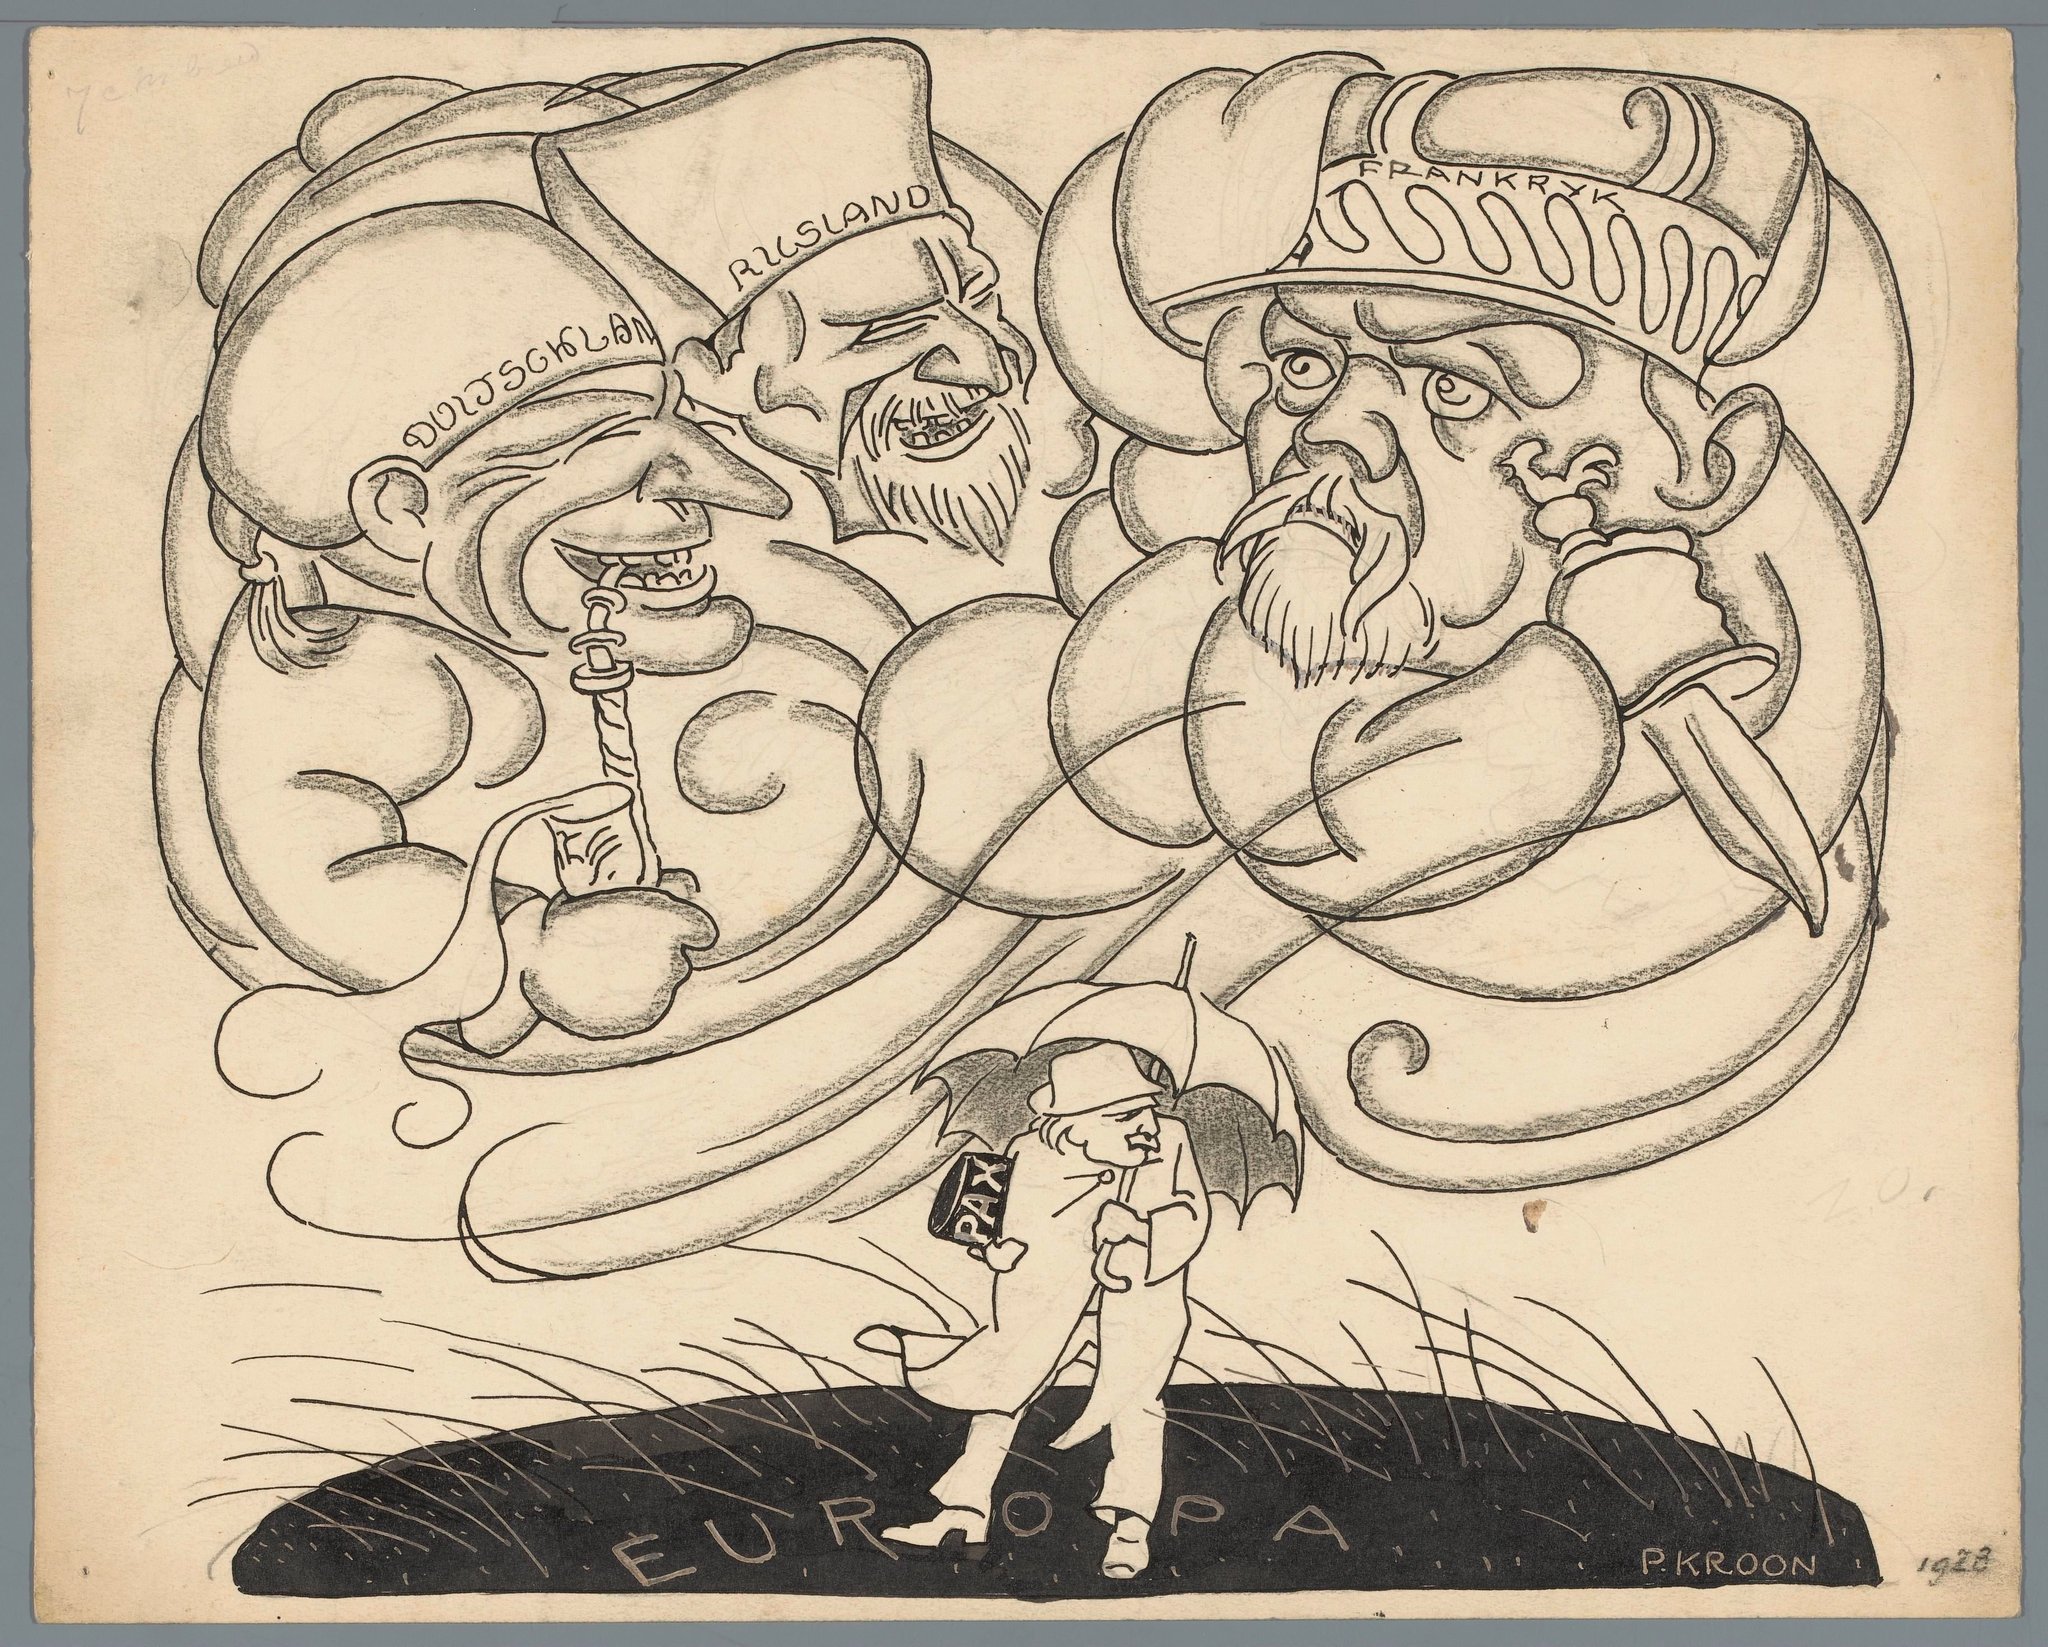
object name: cartoon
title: De Donderbuien in Genua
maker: patricq kroon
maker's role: draughtsman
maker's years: 1862-1941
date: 1922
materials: paper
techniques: brush, pen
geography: netherlands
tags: political caricatures and satires, russia, germany, france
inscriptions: number: ‘19616’, inscription: ‘De Donderbuien in Genua. Lloyd George: Is dat gedonder daar boven nog niet uit?! ...’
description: Lloyd George met paraplu en vredesverdag om de arm, boven hem in de donderwolken Duitsland, Rusland en Frankrijk. Naar aanleiding van de Conferentie van Genua in april-mei 1922. Ontwerp voor een politieke spotprent.